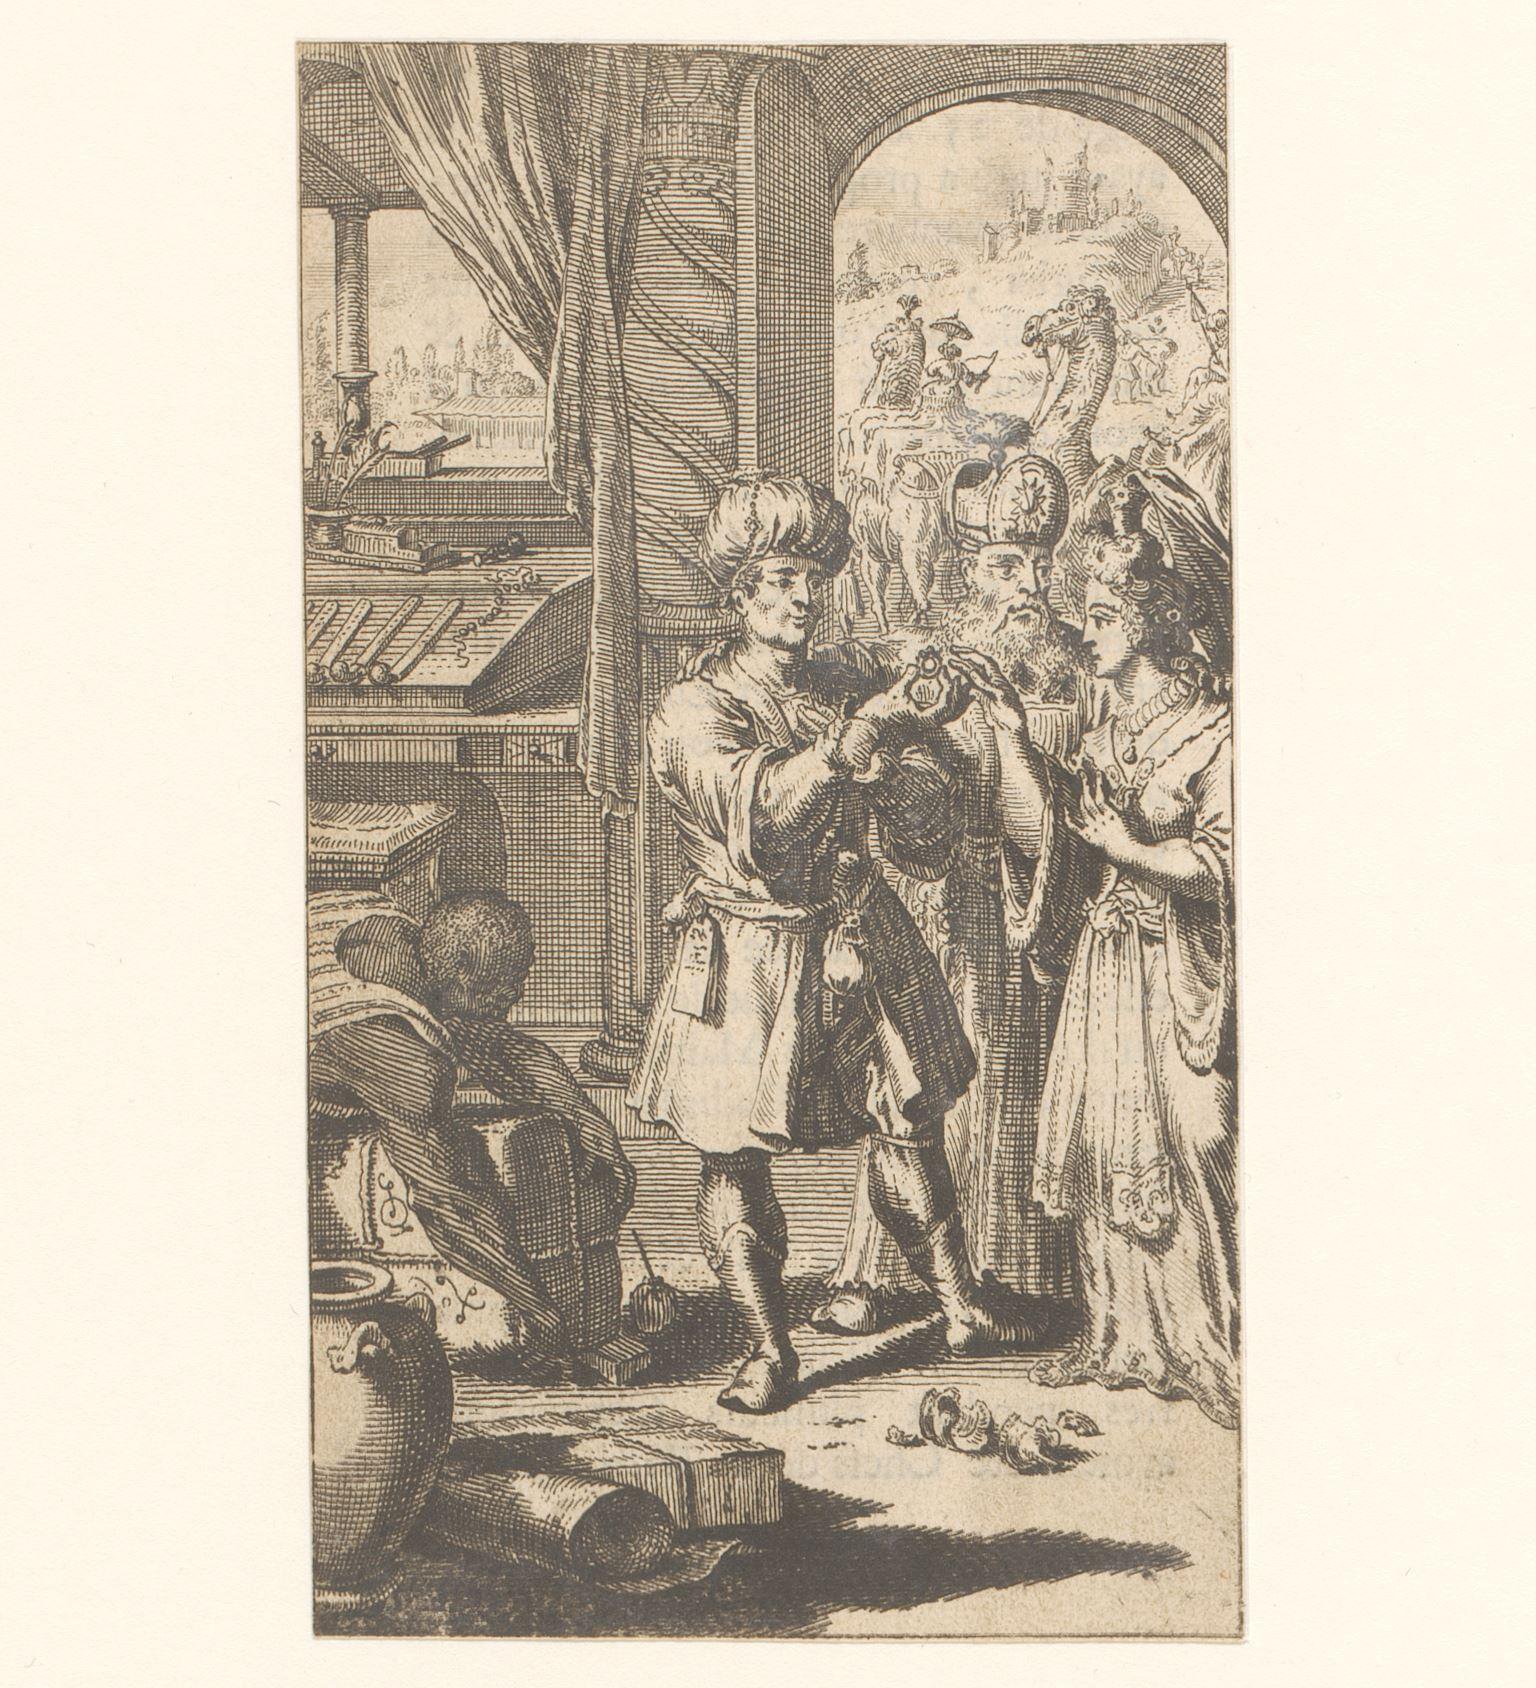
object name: print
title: Huwelijksvoltrekking tussen Mohammed en Chadidja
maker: george gallet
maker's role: publisher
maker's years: -1724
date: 1699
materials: paper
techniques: etching, letterpress printing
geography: amsterdam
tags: hoofed animals: camel, (civil) marriage ceremonies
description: Prent uit: Prideaux, Humphrey. La vie de Mahomet, où l'on découvre amplement la verité de l'imposture. Amsterdam: George Gallet, 1699, p. 14.